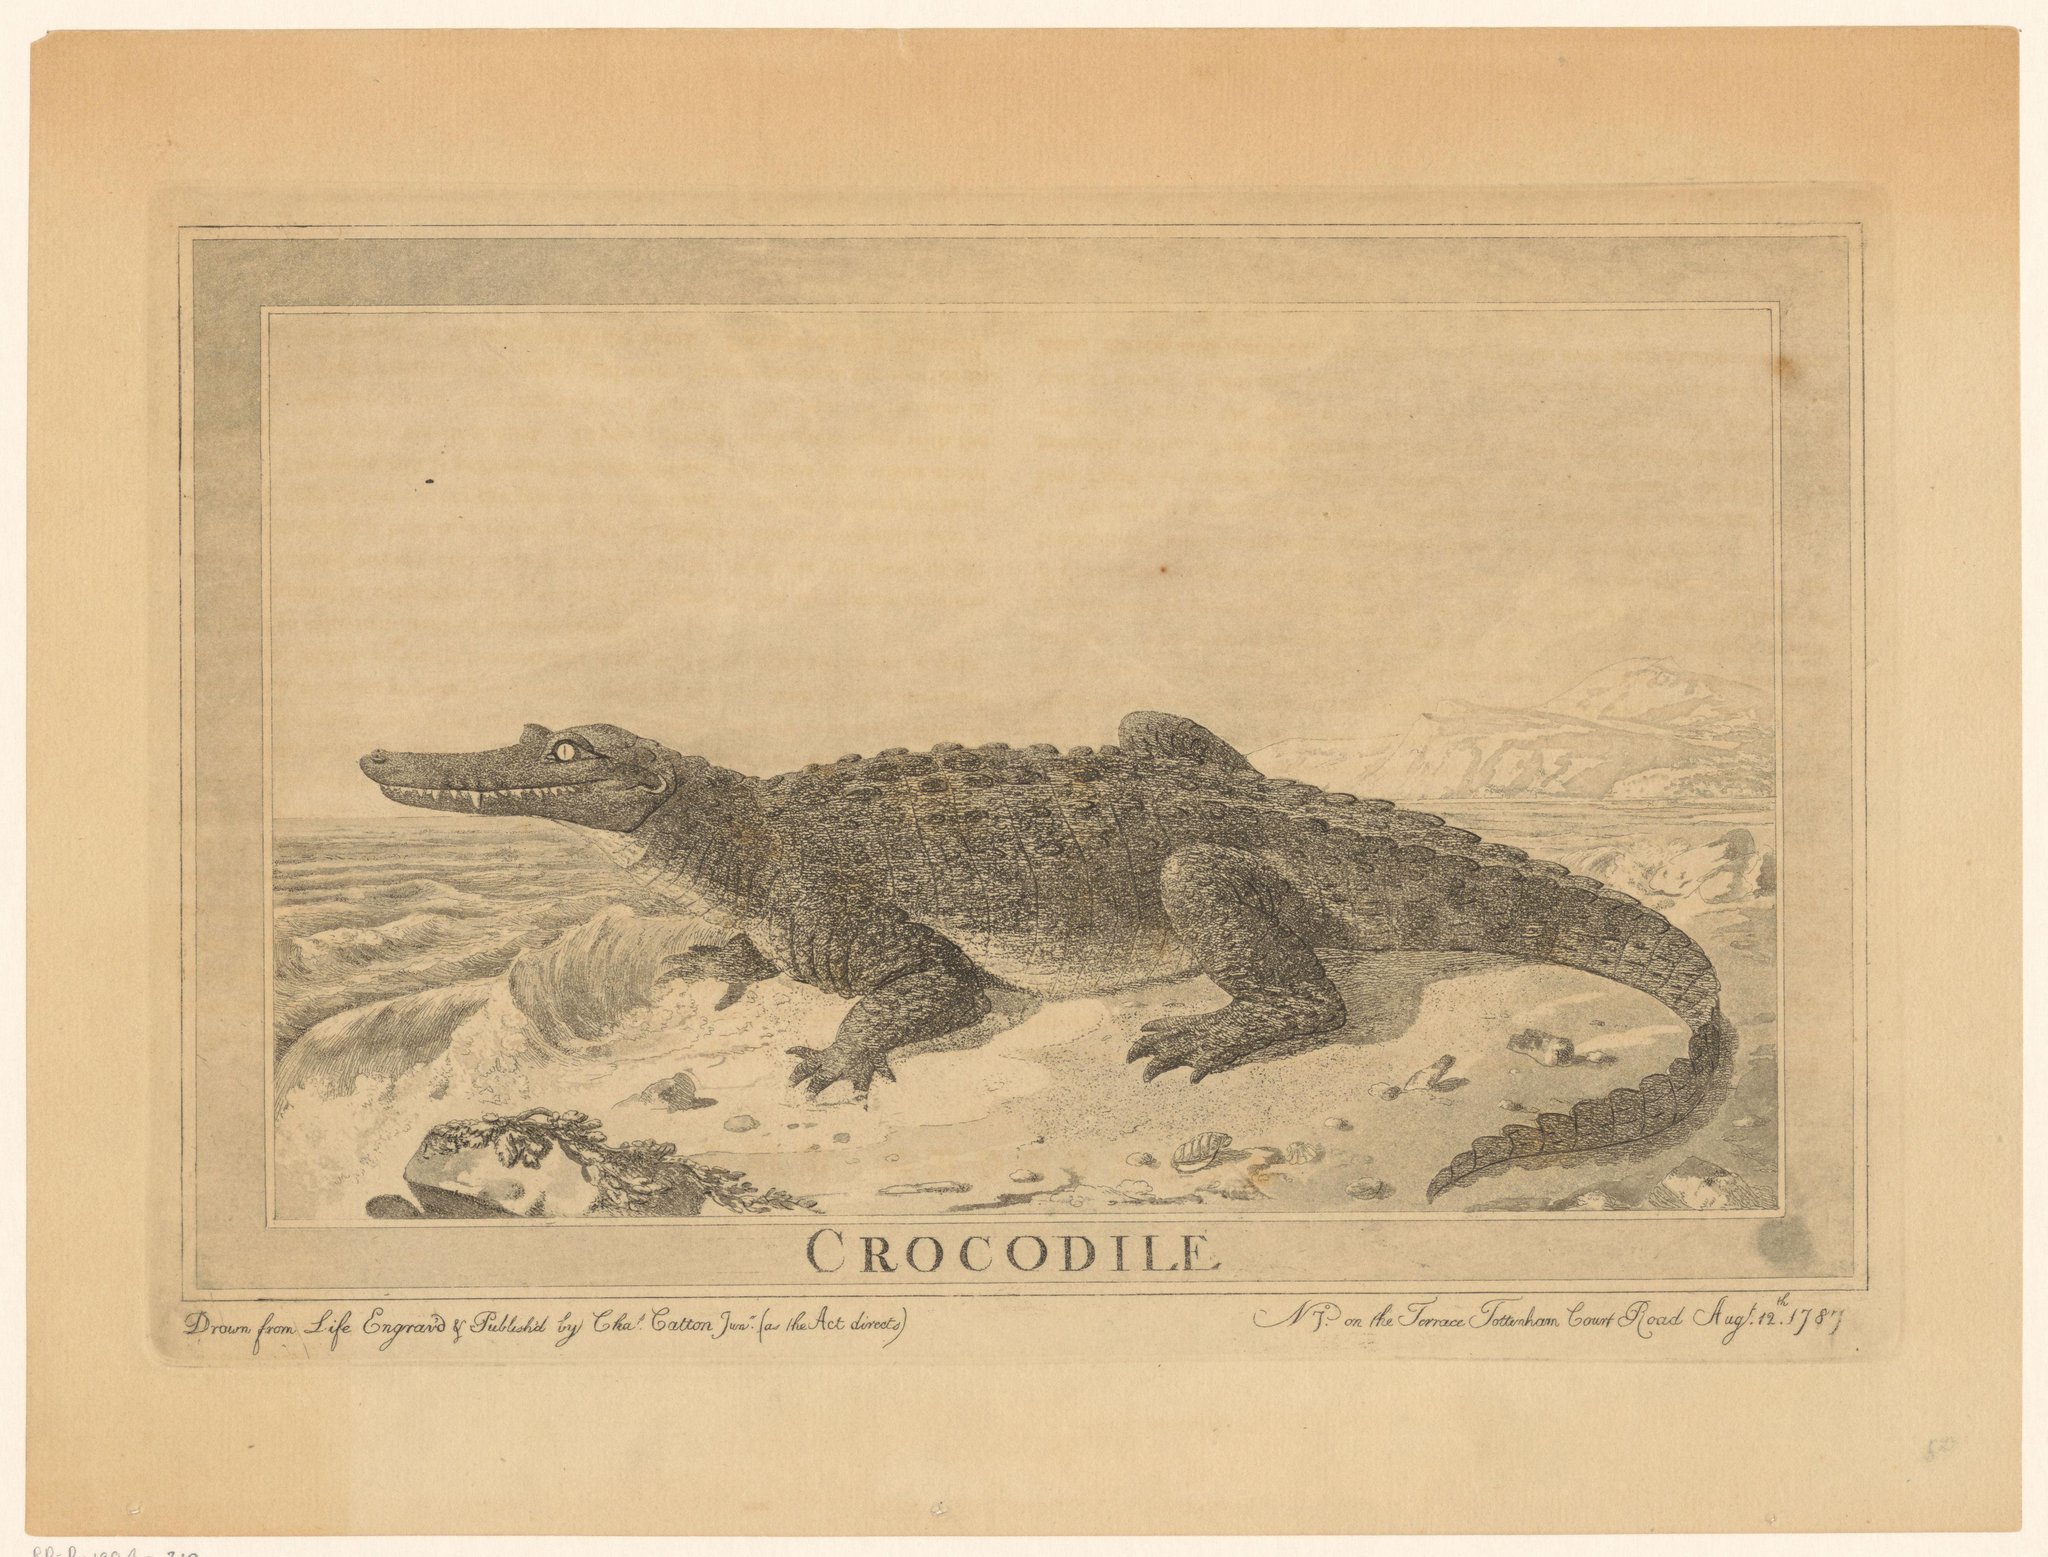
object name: print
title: Crocodile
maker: charles catton (ii)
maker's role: painter, print maker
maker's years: 1756-1819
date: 1787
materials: paper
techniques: aquatint, etching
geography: united states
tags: crocodiles: alligator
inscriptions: collector's mark: Lugt 2228